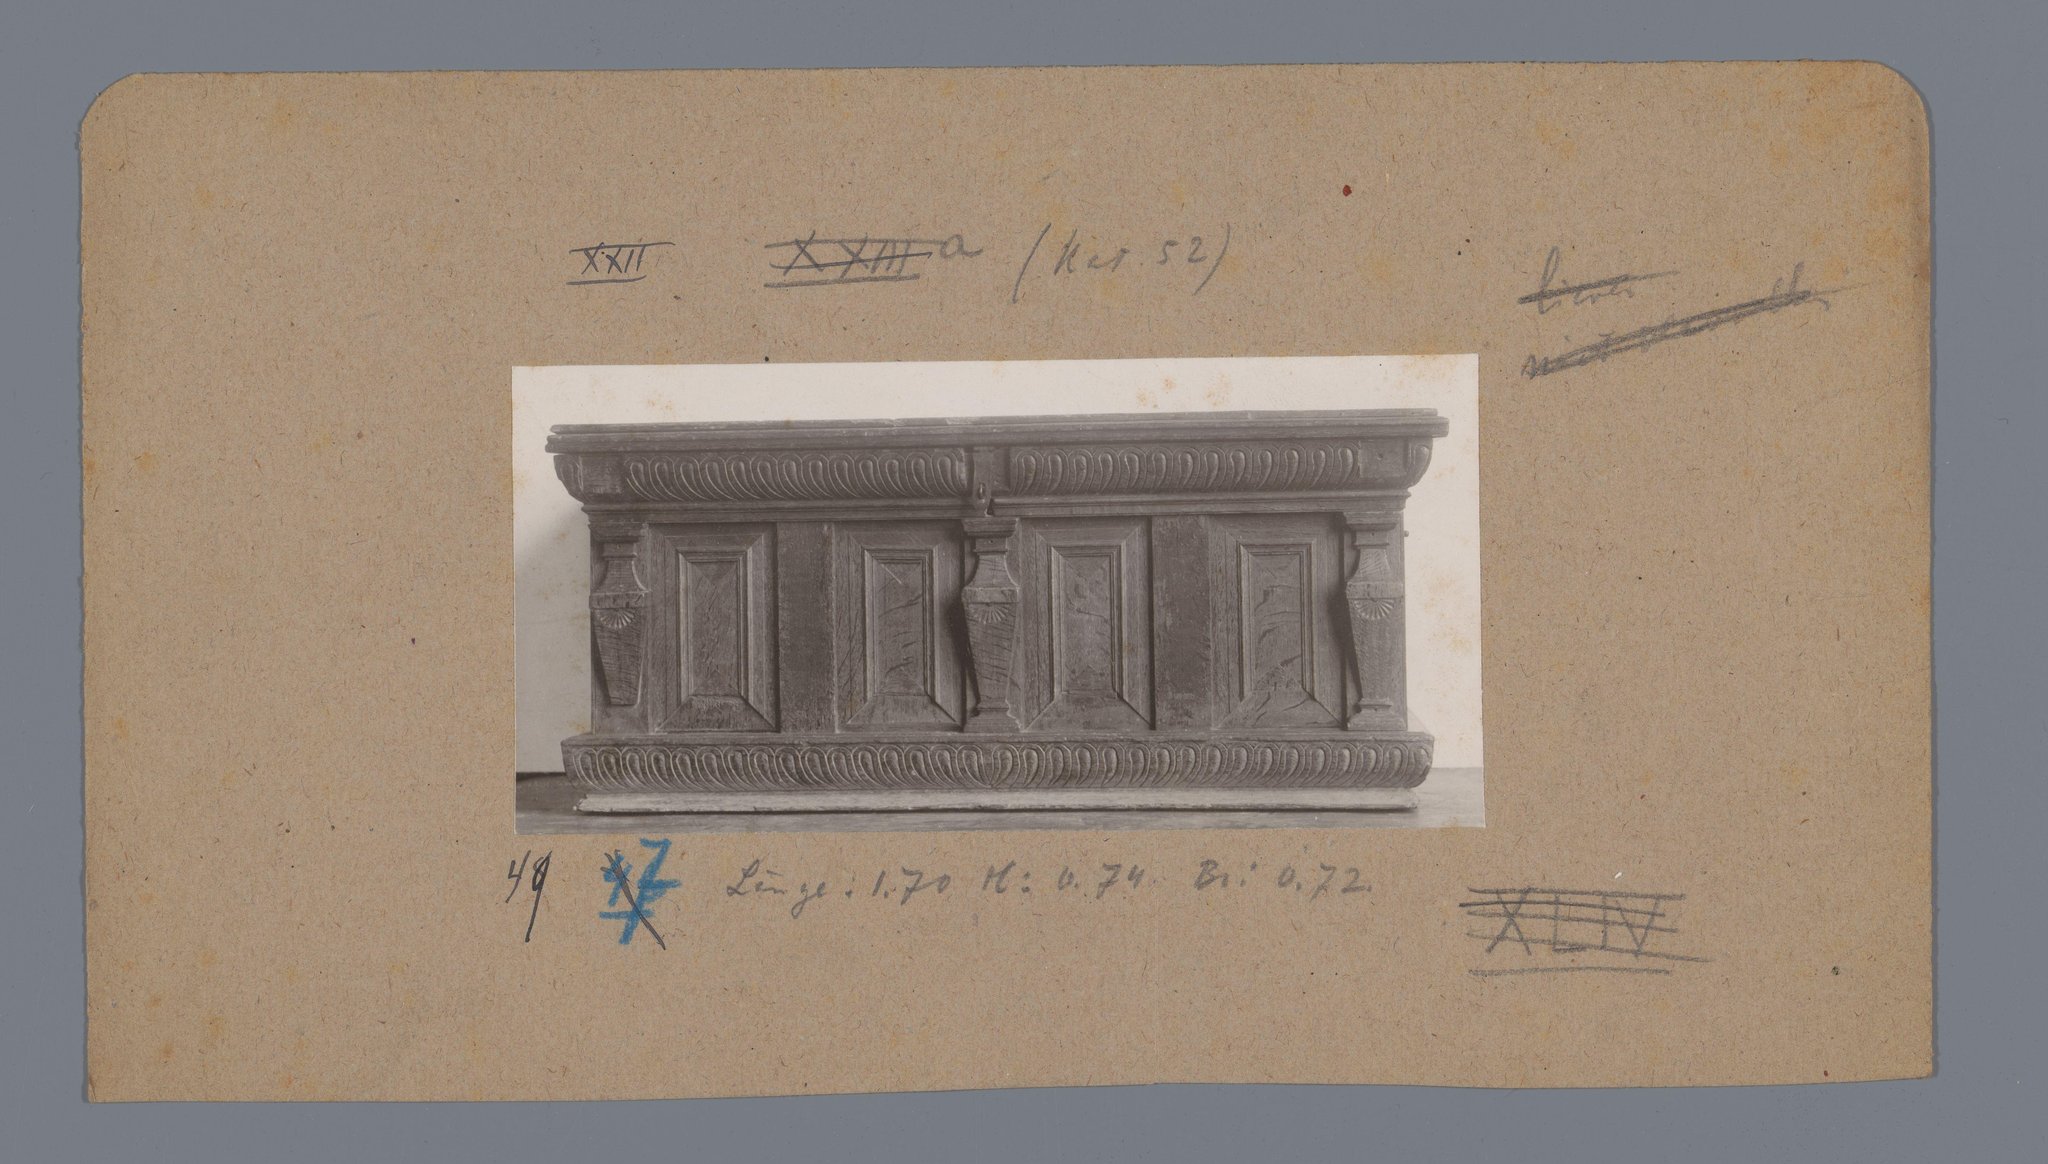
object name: photograph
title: Kist (vermoedelijk) in het Rijksmuseum te Amsterdam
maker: Anonymous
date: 1875-1900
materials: photographic support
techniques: matte daylight collodion silver print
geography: amsterdam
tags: chest, coffer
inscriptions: number: ‘XXII (Kat. 52) 49’, collector's mark: ‘Kunstnijverheidschool Quellinus Amsterdam Frans Halsstraat 14.’, collector's mark: ‘Instituut voor kunst-nijverheidsonderwijs Gabriël Metsustraat No. 16, Amsterdam’